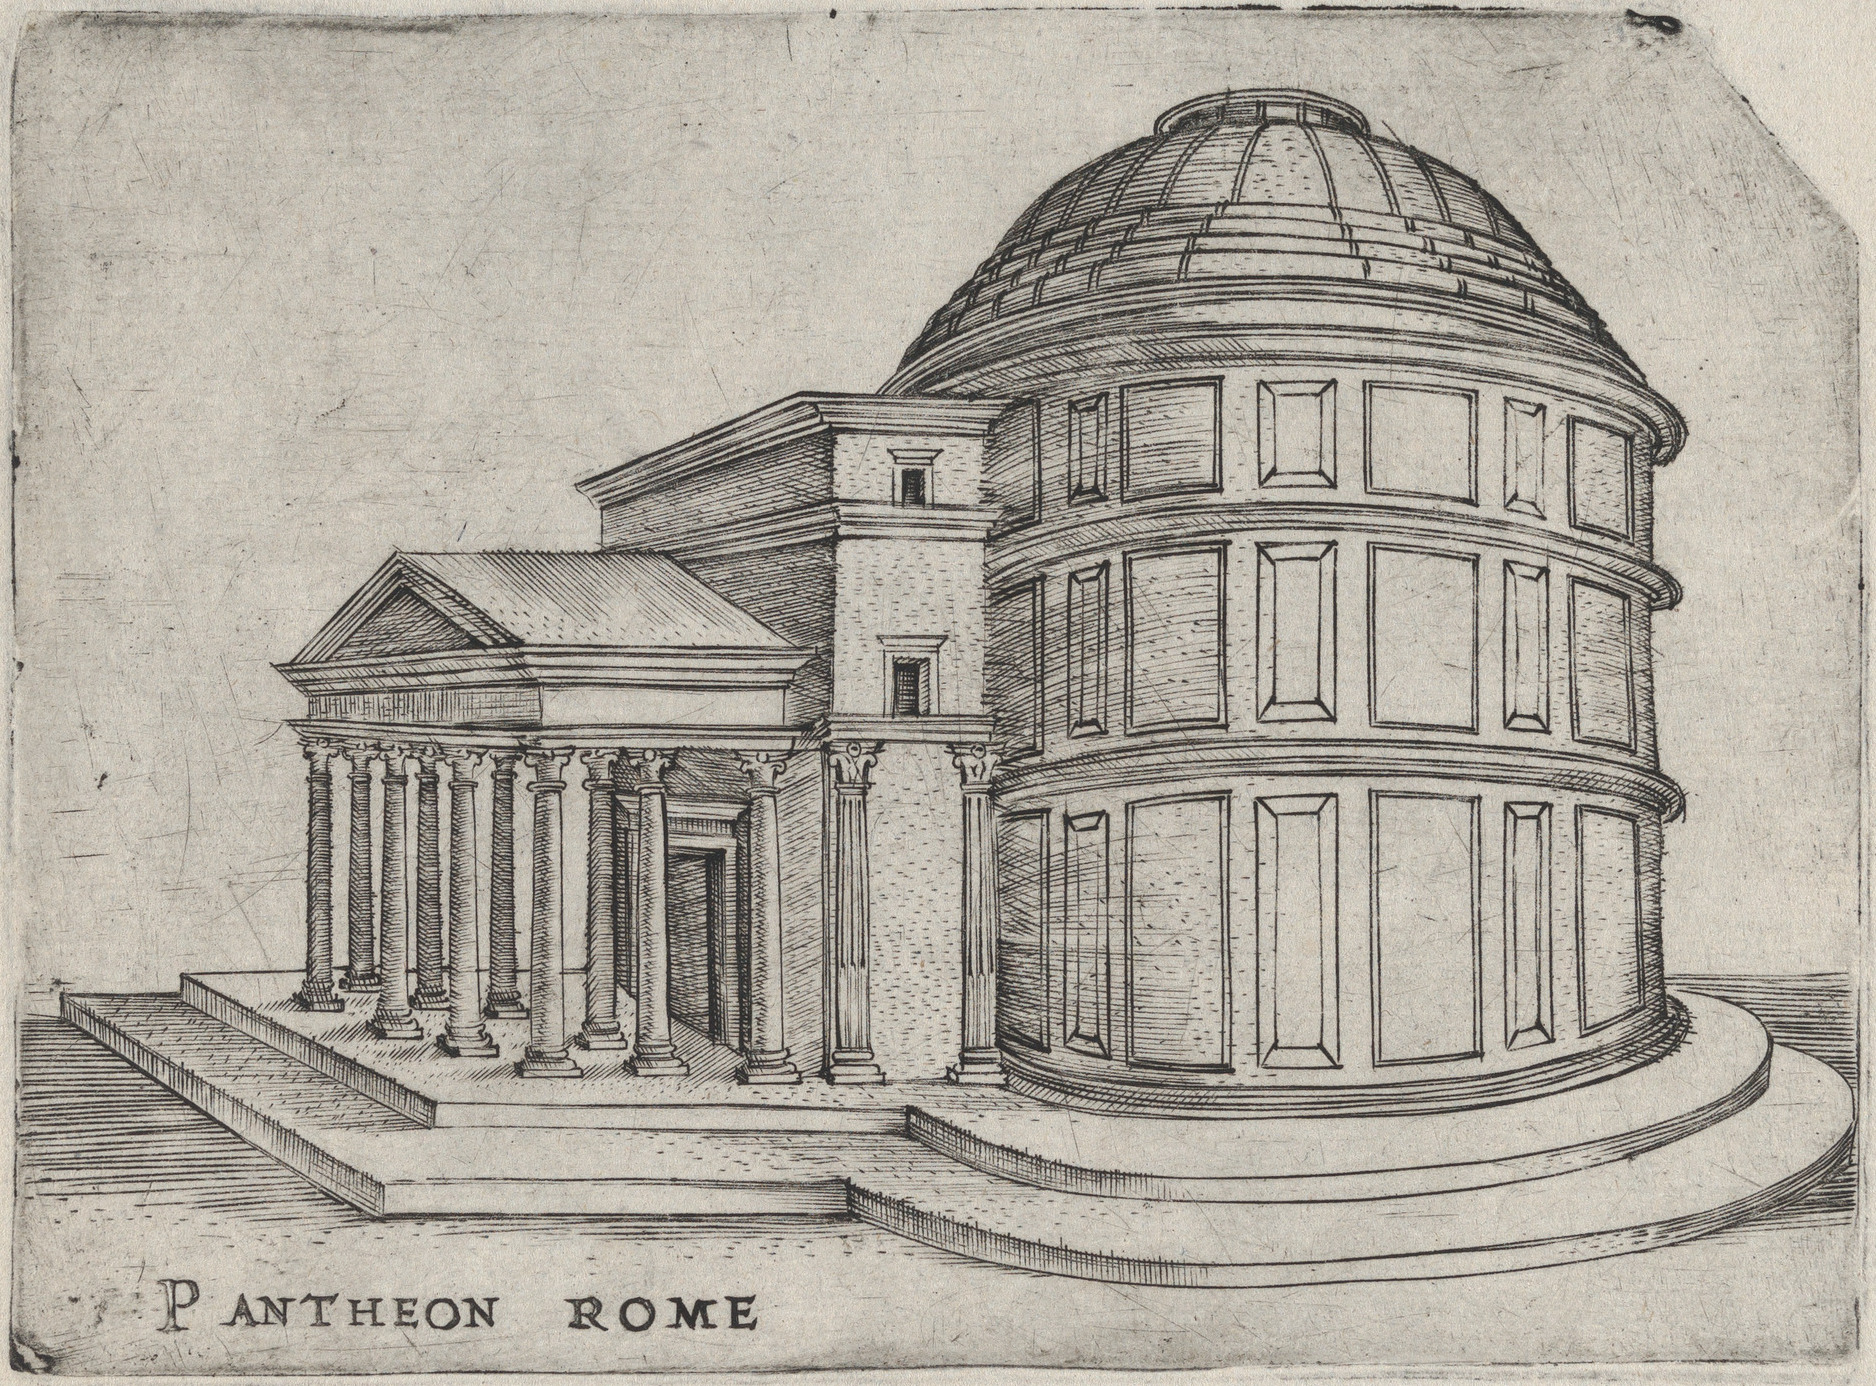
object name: print ornament architecture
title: Pantheon Rome, from a Series of 24 Depicting (Reconstructed) Buildings from Roman Antiquity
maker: anonymous, italian, 16th century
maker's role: artist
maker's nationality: italian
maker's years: 1500-1600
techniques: engraving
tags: architecture,buildings